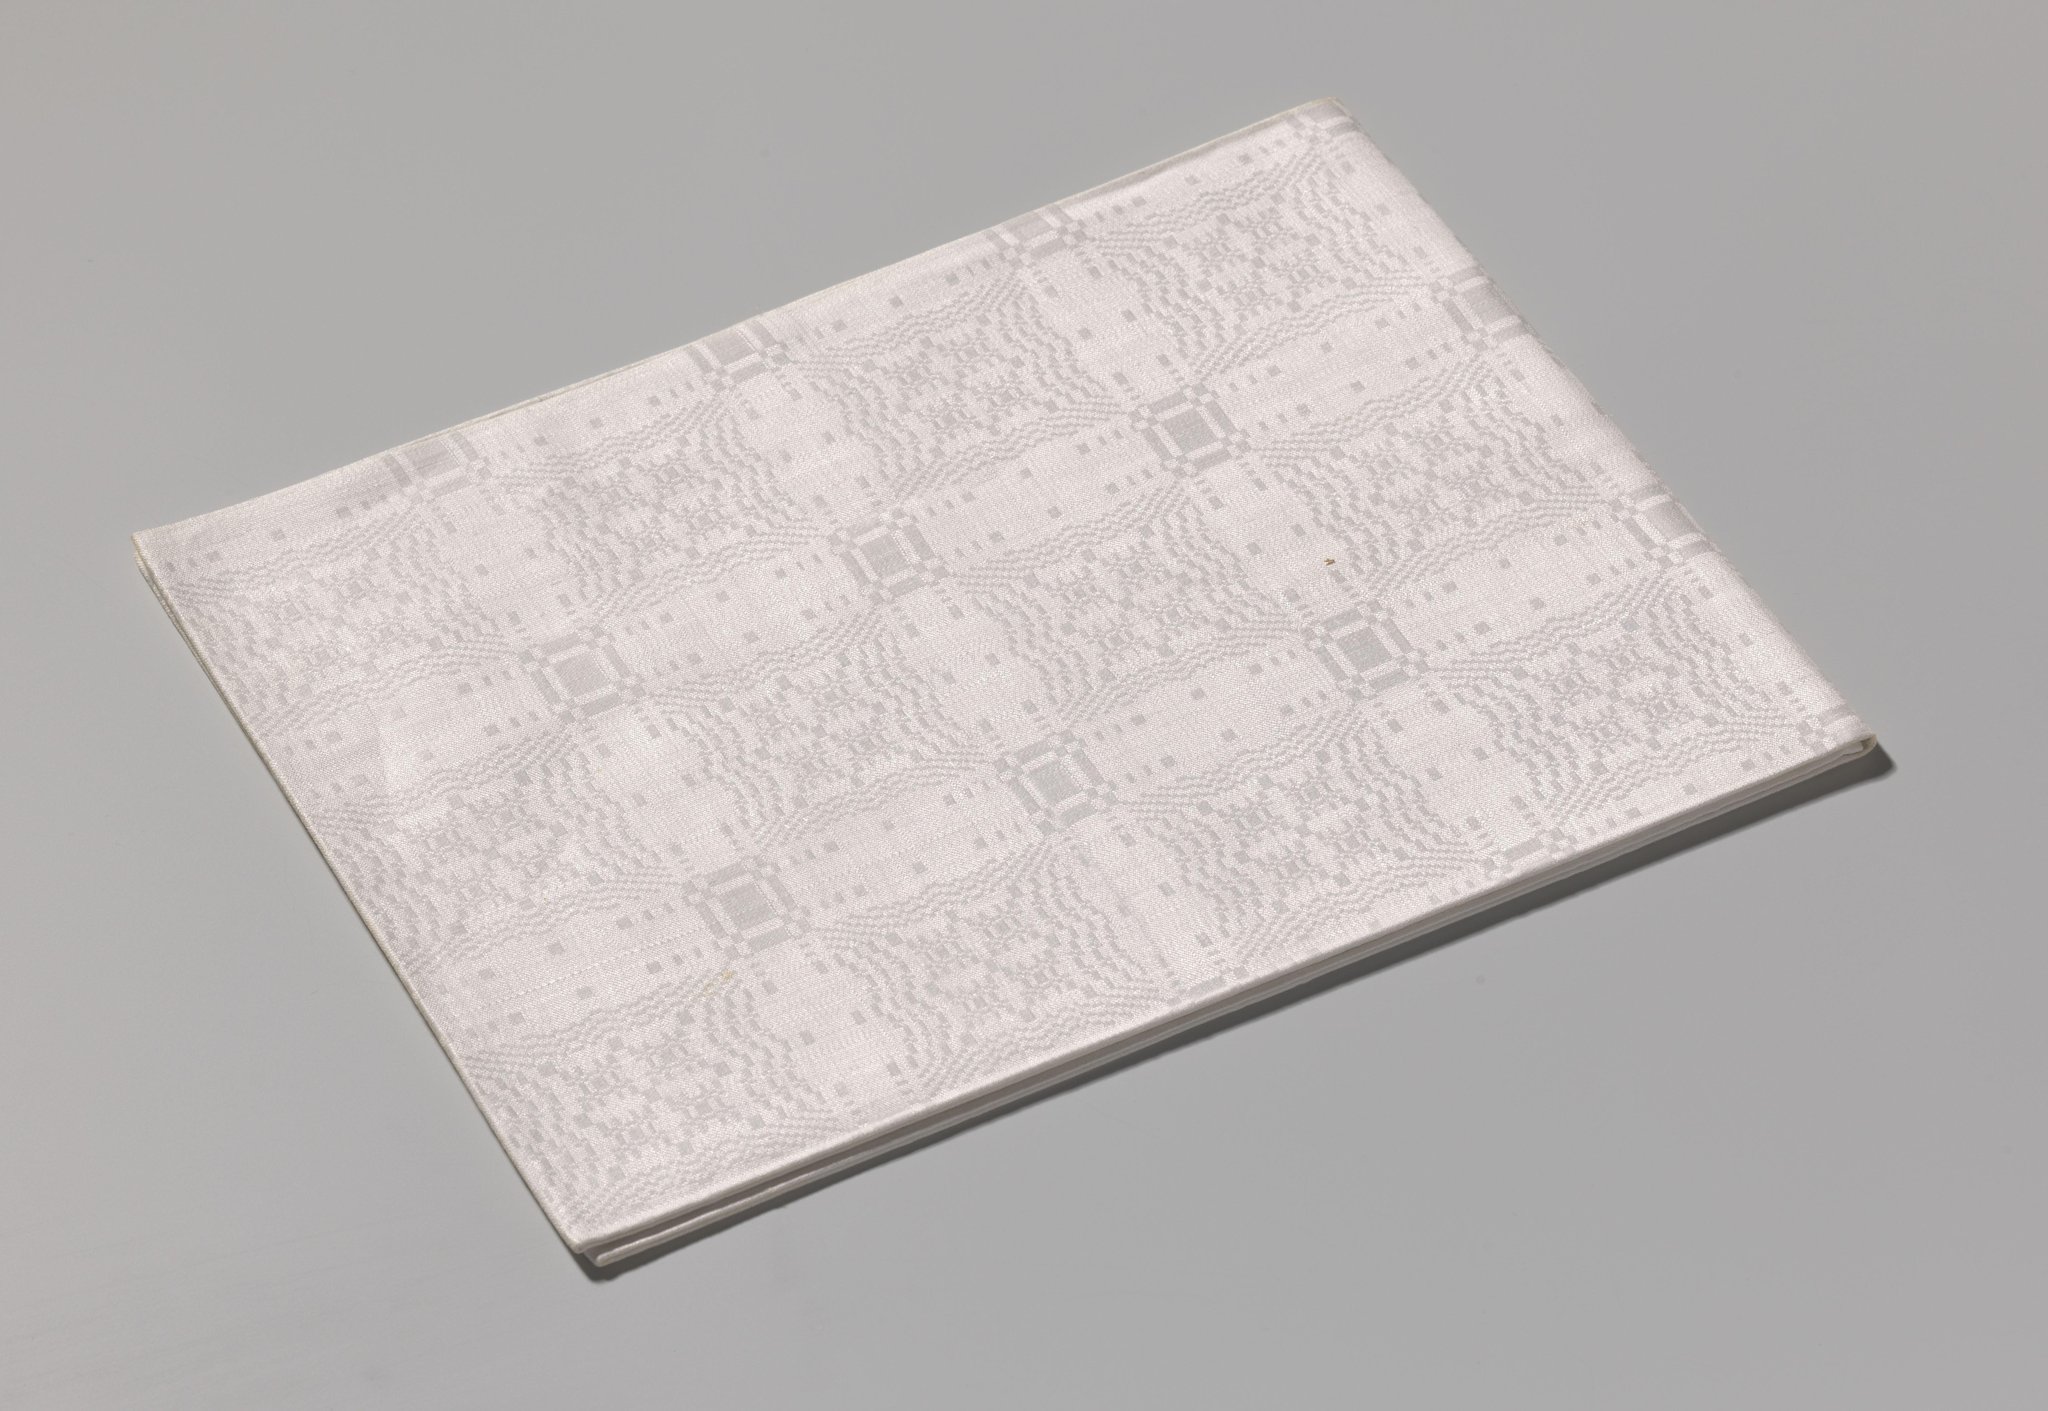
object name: napkin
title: Servet van linnen met pellenpatroon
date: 1400-1950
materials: linen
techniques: peeled fabric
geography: northern netherlands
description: Wit linnendamasten servet met pellenpatroon, merk kroon IS en 96.